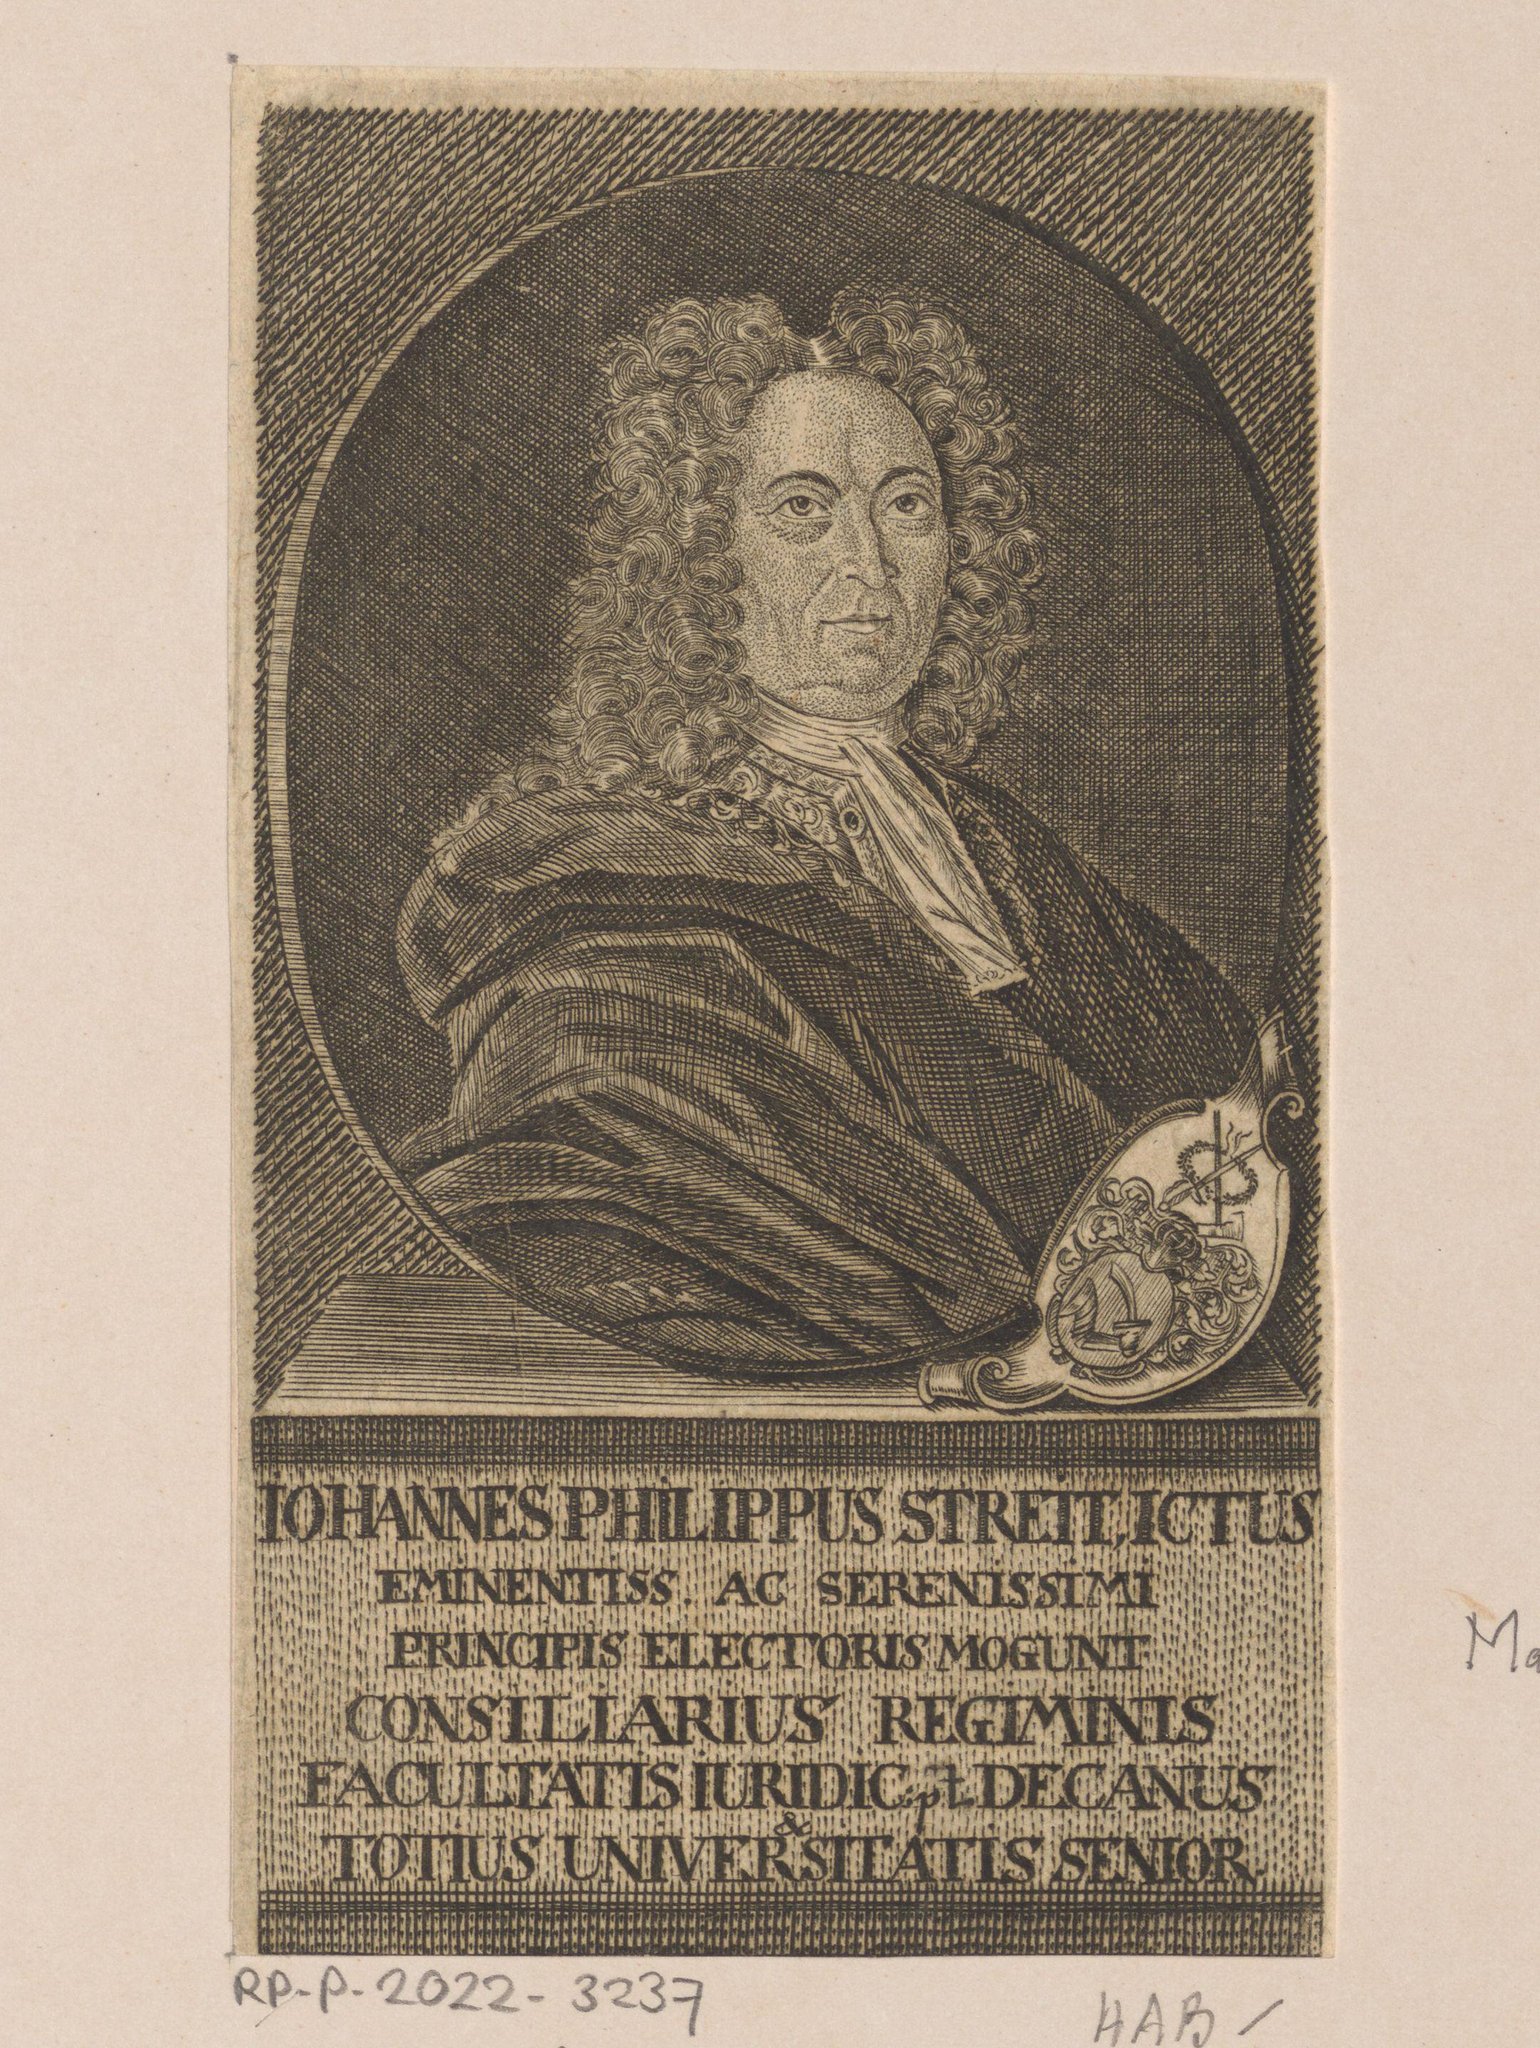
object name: print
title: Portret van Johann Philipp Streit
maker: Anonymous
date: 1693-1750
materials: paper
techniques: engraving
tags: historical persons, lawyer, attorney at law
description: Met zesregelig onderschrift in het Latijn.